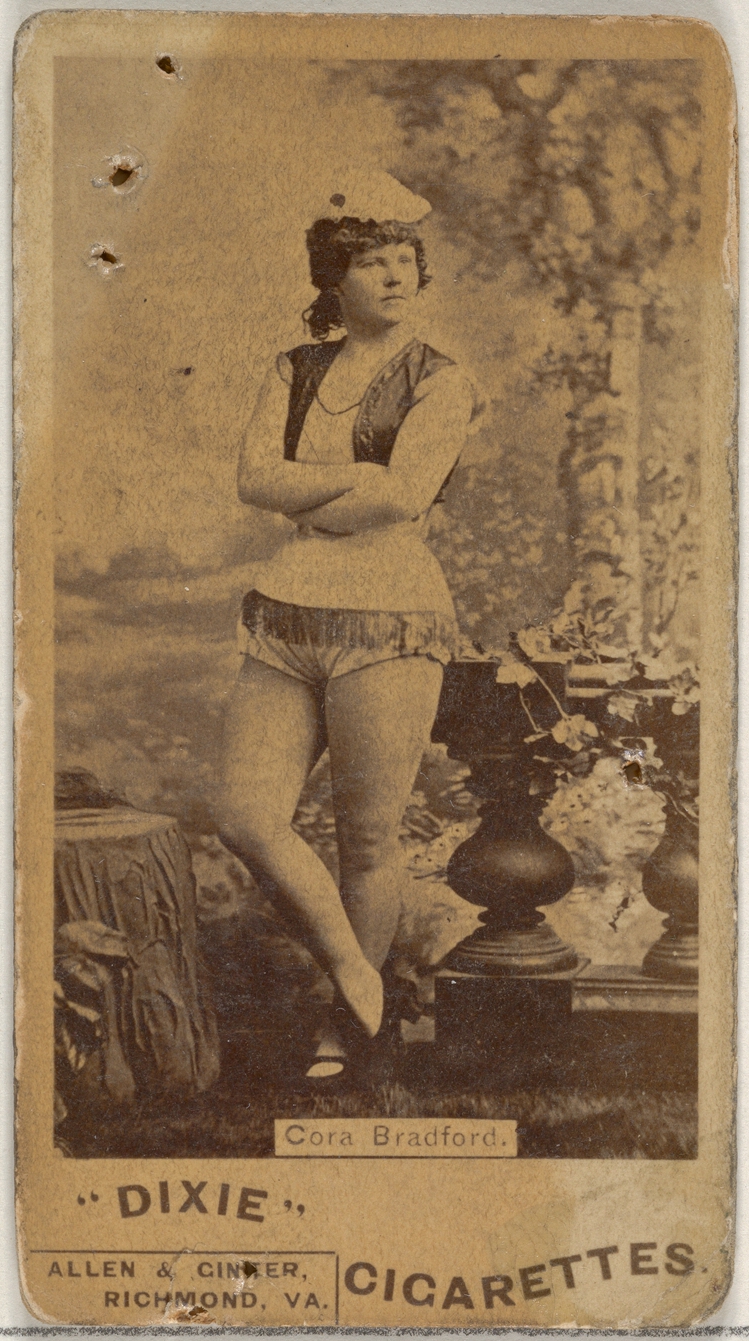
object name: photograph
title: Cora Bradford, from the Actors and Actresses series (N45, Type 7) for Dixie Cigarettes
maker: allen & ginter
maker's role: publisher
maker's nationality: american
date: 1888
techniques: albumen silver print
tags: portraits,women,actresses